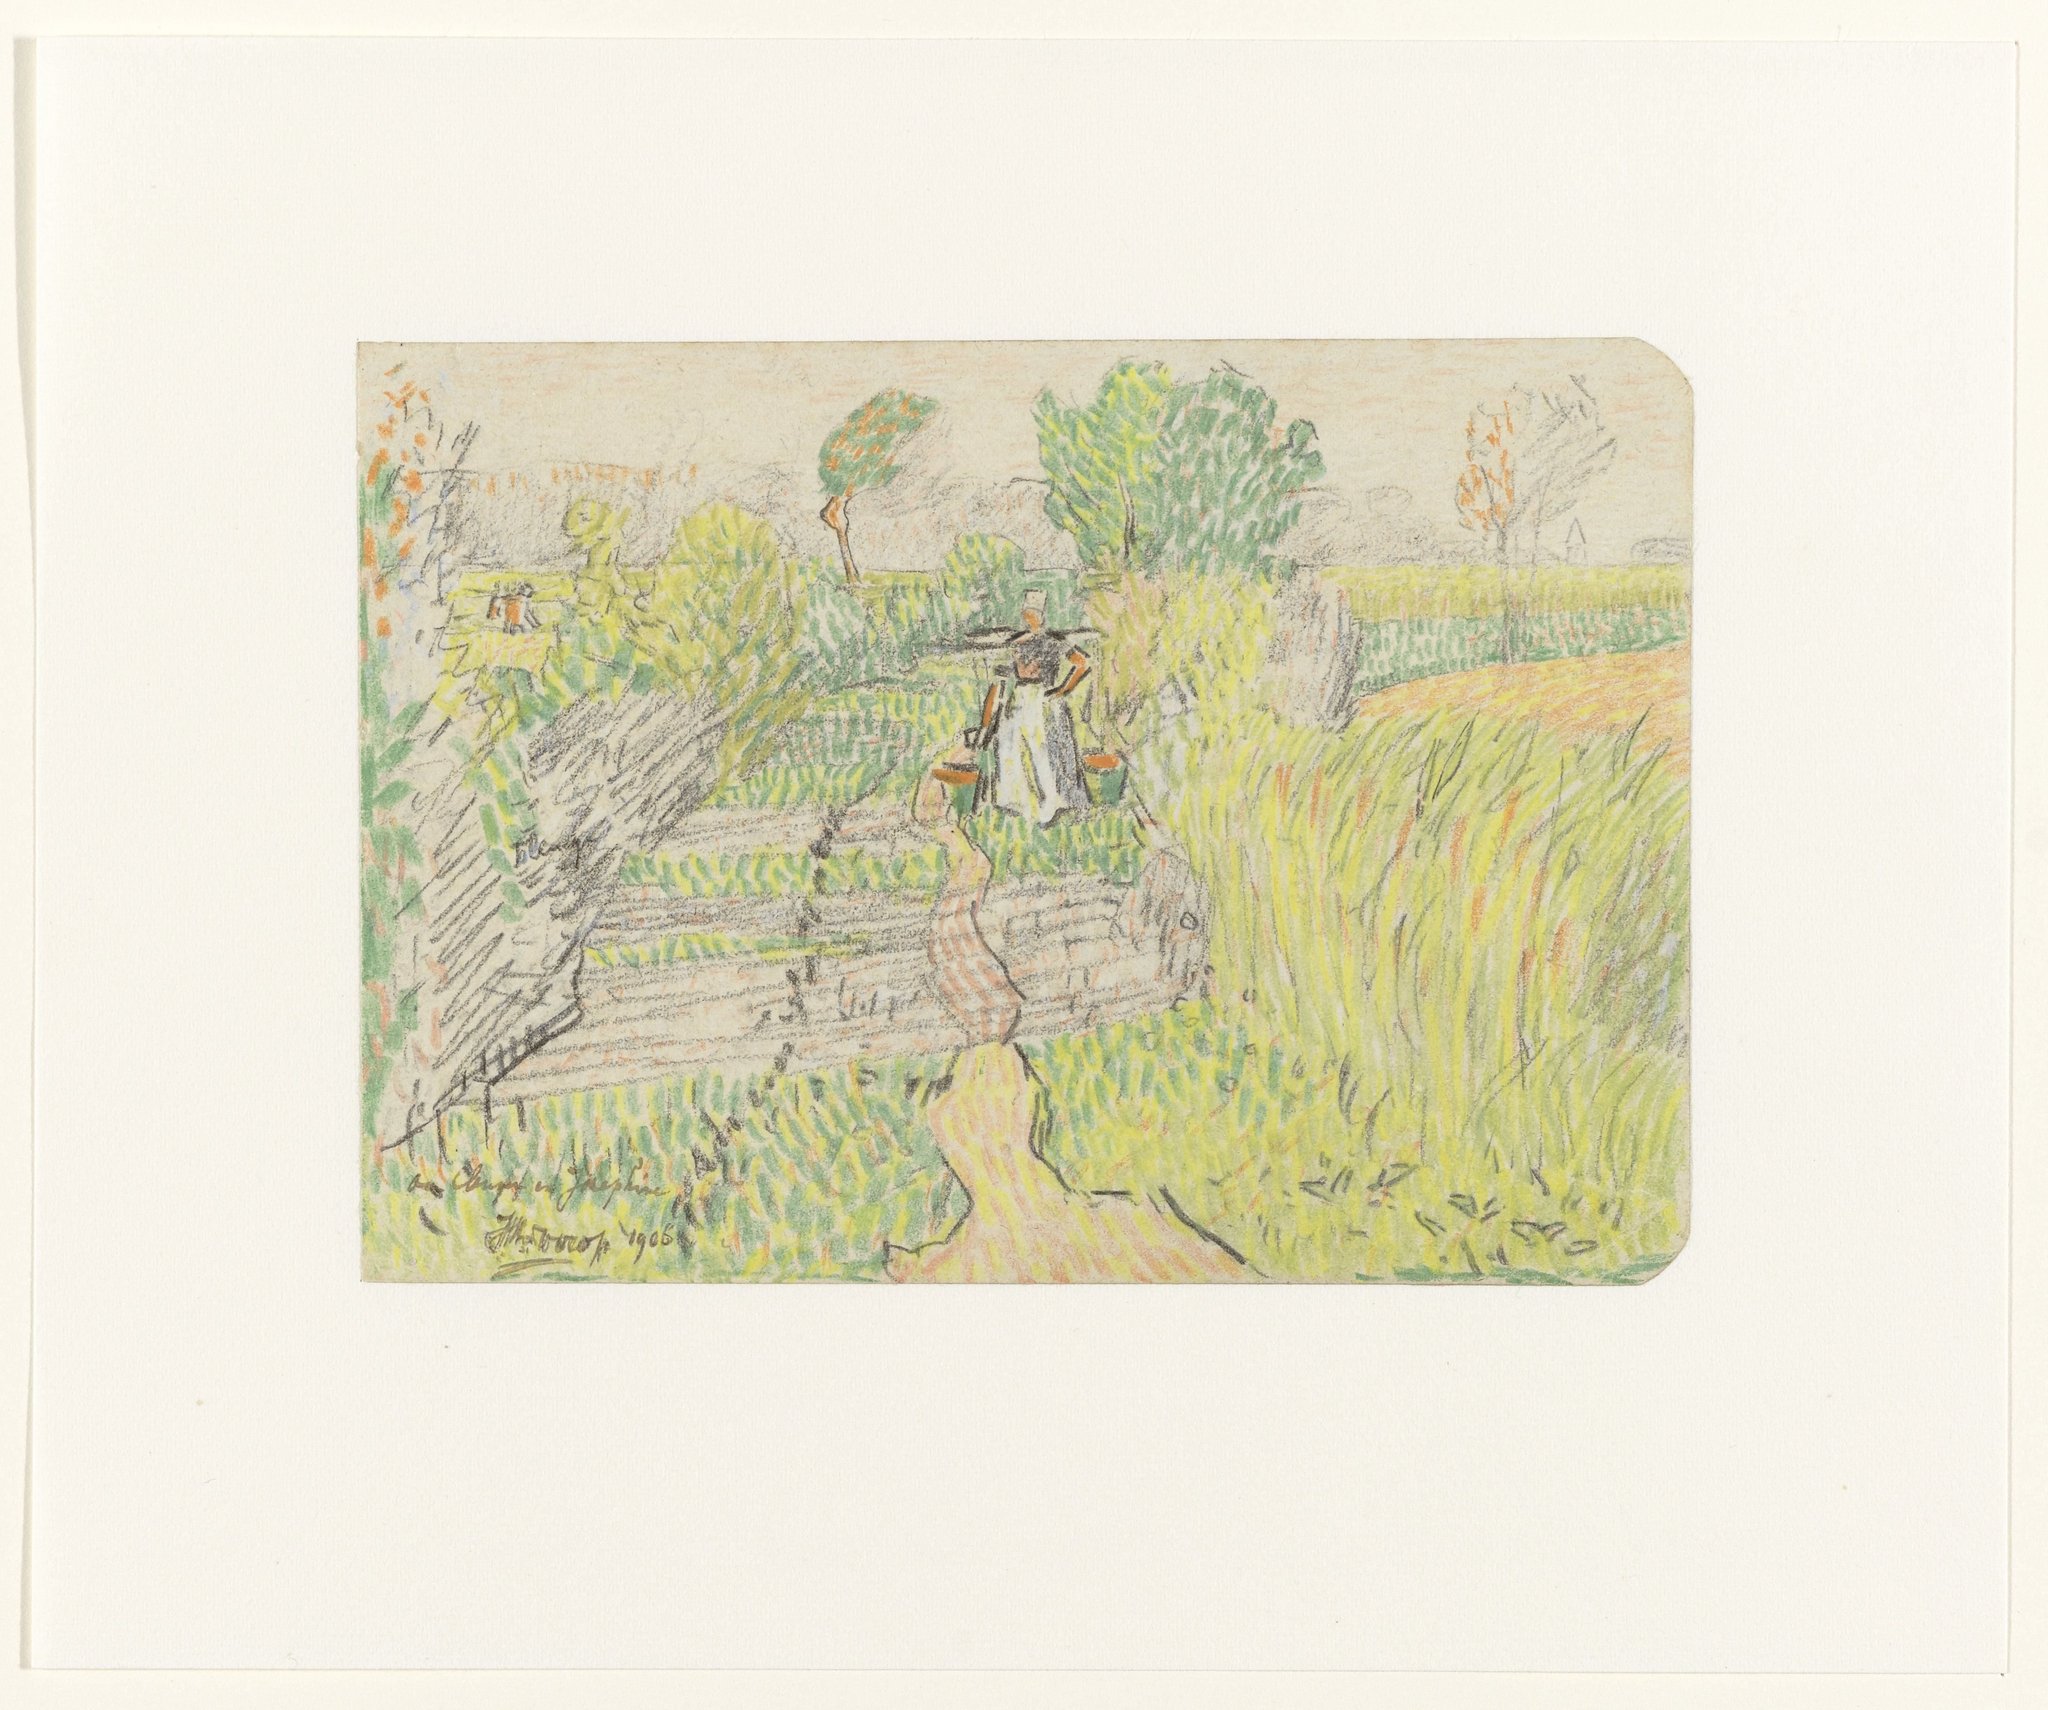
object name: drawing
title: Boerin met juk met melkemmers op de schouders, lopend door een korenveld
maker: jan toorop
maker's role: draughtsman, painter, print maker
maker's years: 1858-1928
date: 1906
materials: chalk, paper